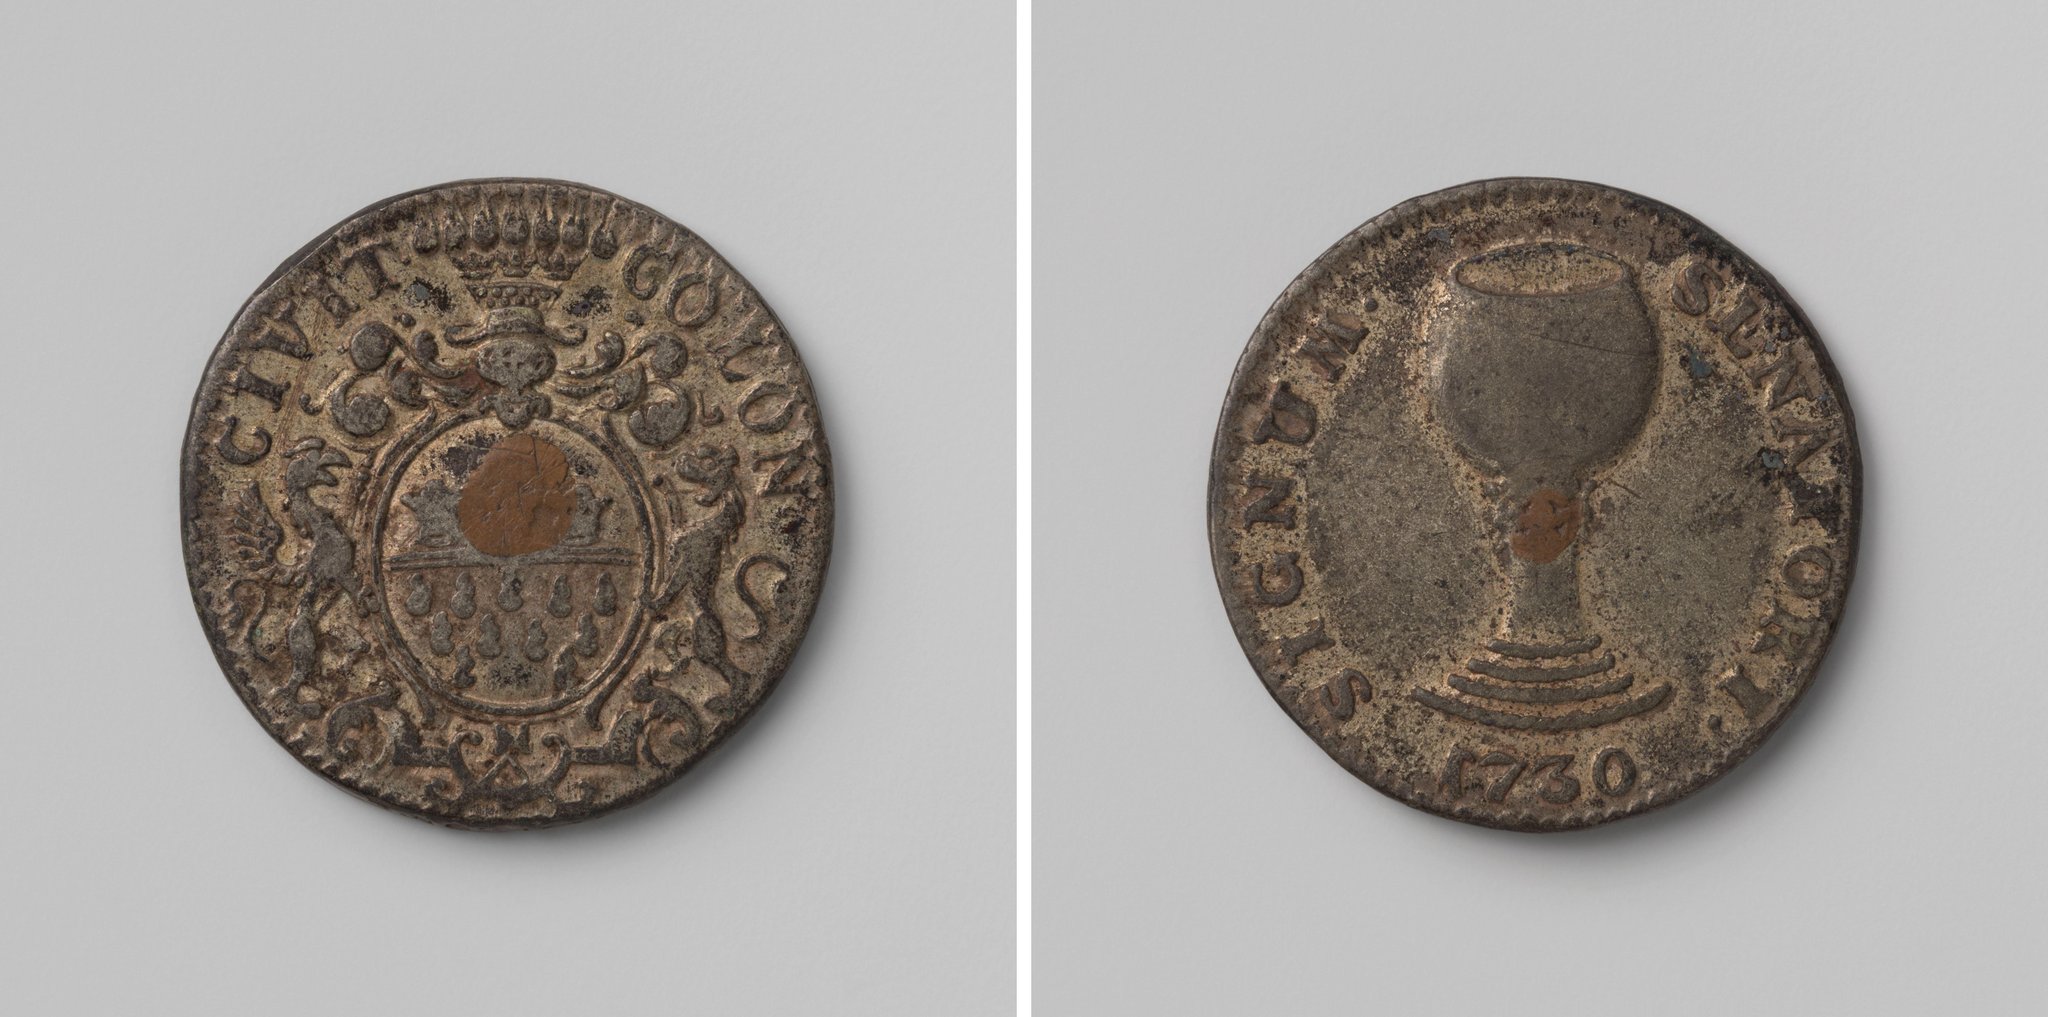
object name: council medal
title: Vroedschapspenning van de stad Keulen, penning uitgereikt aan de leden van de stadsraad recht gevend op een kan bier of wijn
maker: Anonymous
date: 1730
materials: metal alloy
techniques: striking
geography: cologne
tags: cologne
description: Penning. Voorzijde: gehelmd wapenschild, geflankeerd door griffioen en leeuw binnen omschrift. Keerzijde: kelk met op voet een gezichtje binnen omschrift; randschrift